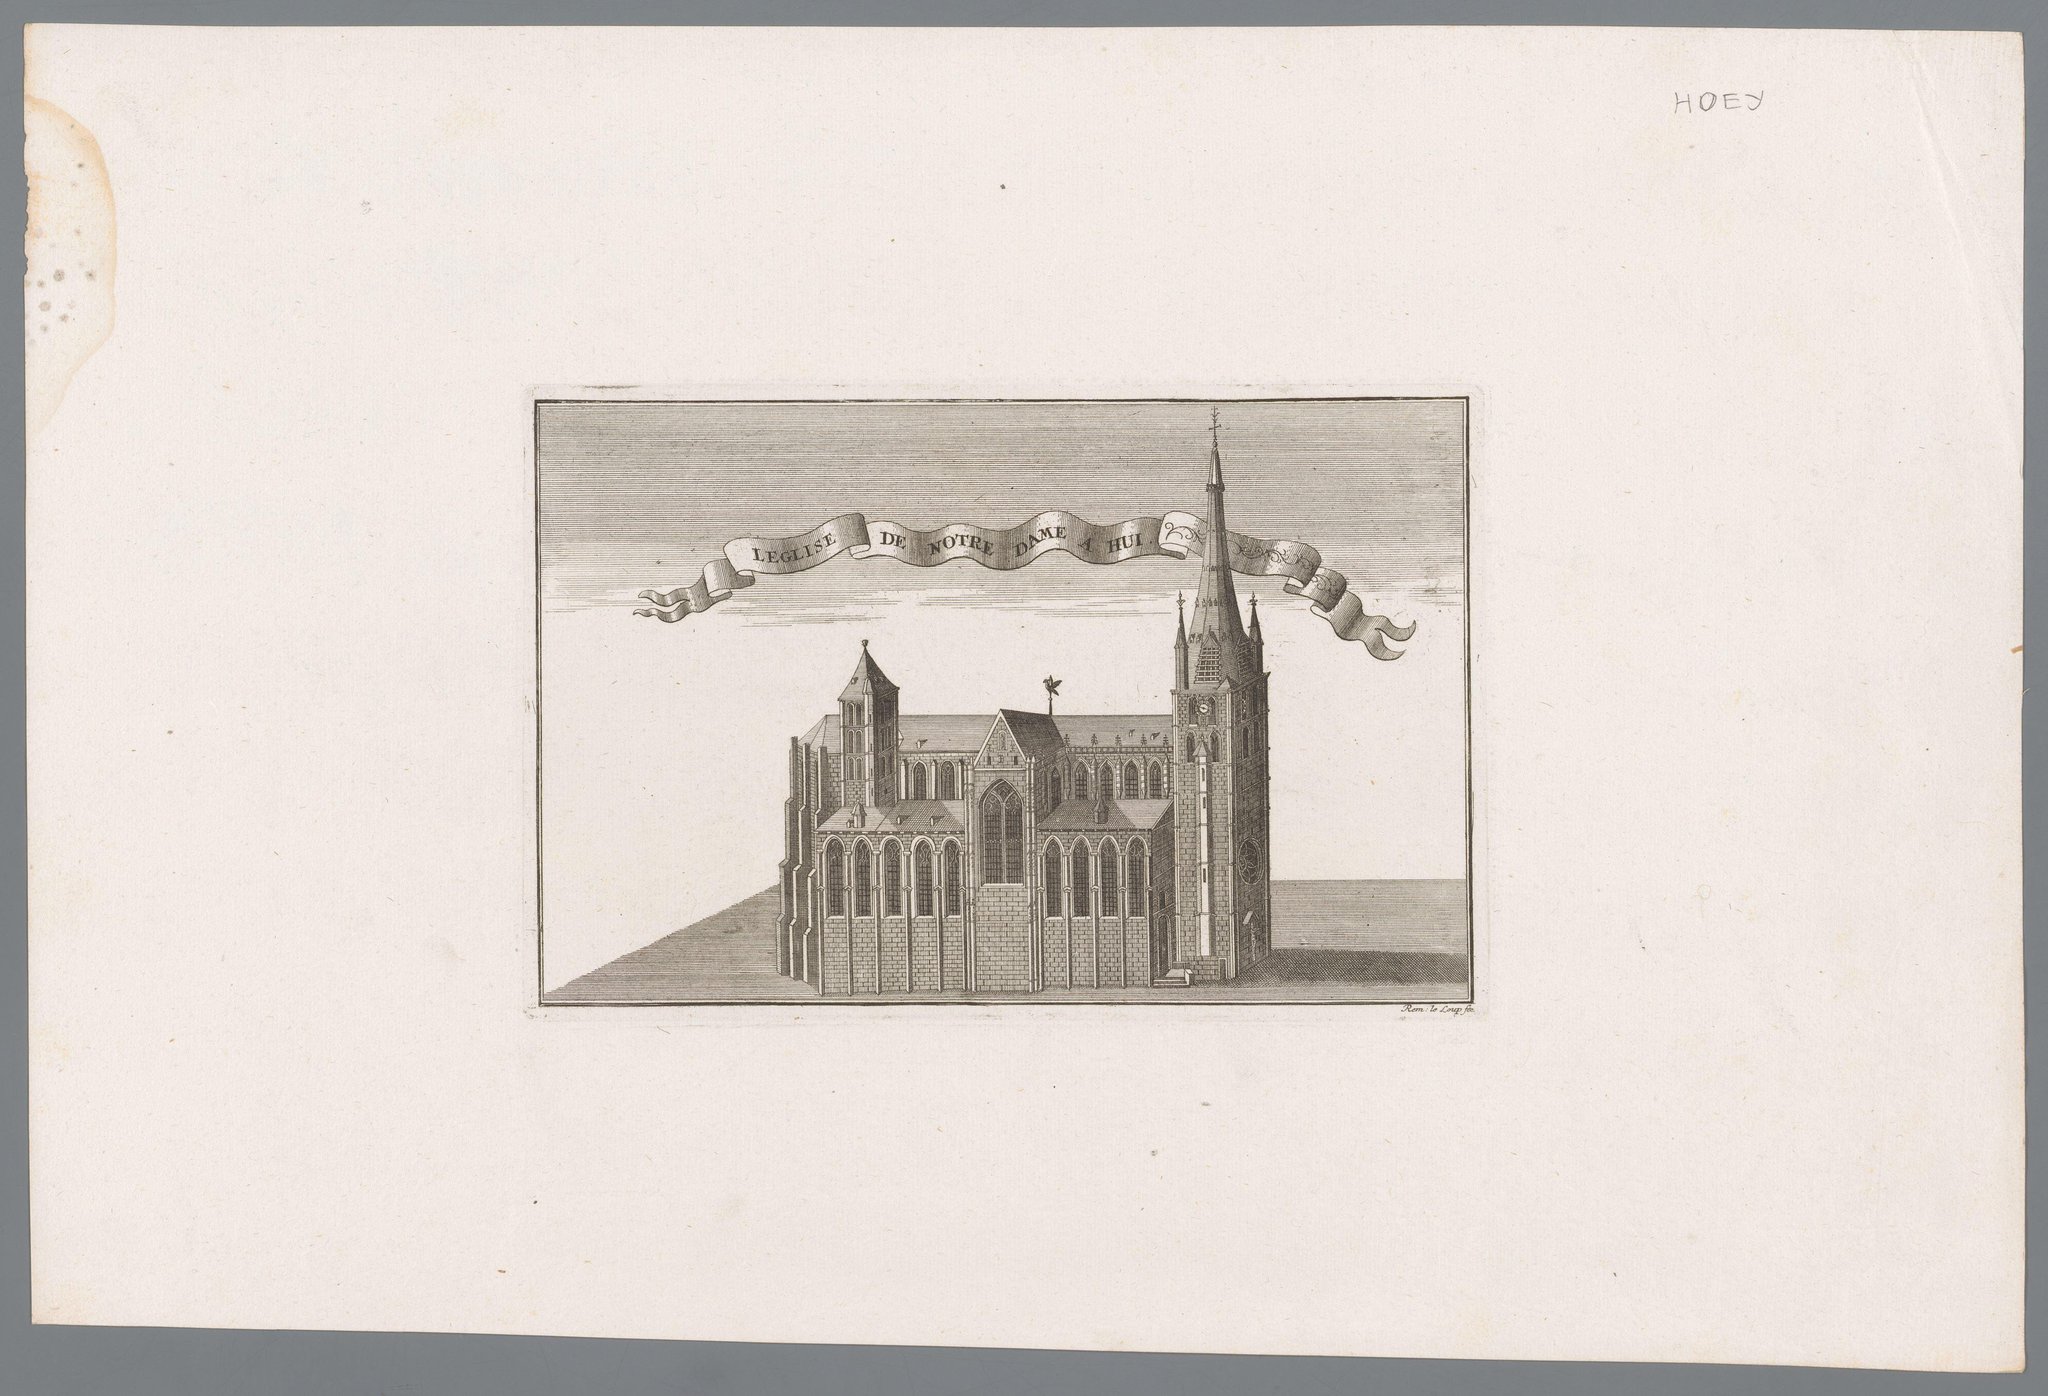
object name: print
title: Gezicht op de kerk Onze-Lieve-Vrouw van Hoei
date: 1738-1744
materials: paper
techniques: engraving, etching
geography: liège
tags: church (exterior)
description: Prent uit: Johanne de Saumery, Alexandre de et al. Les délices du païs de Liège, ou description géographique, topographique et chorographique des monumes sacrés et profanes (...). 5 dln. Luik: Everard Kints, 1738-1744, dl. 2, p. 54.